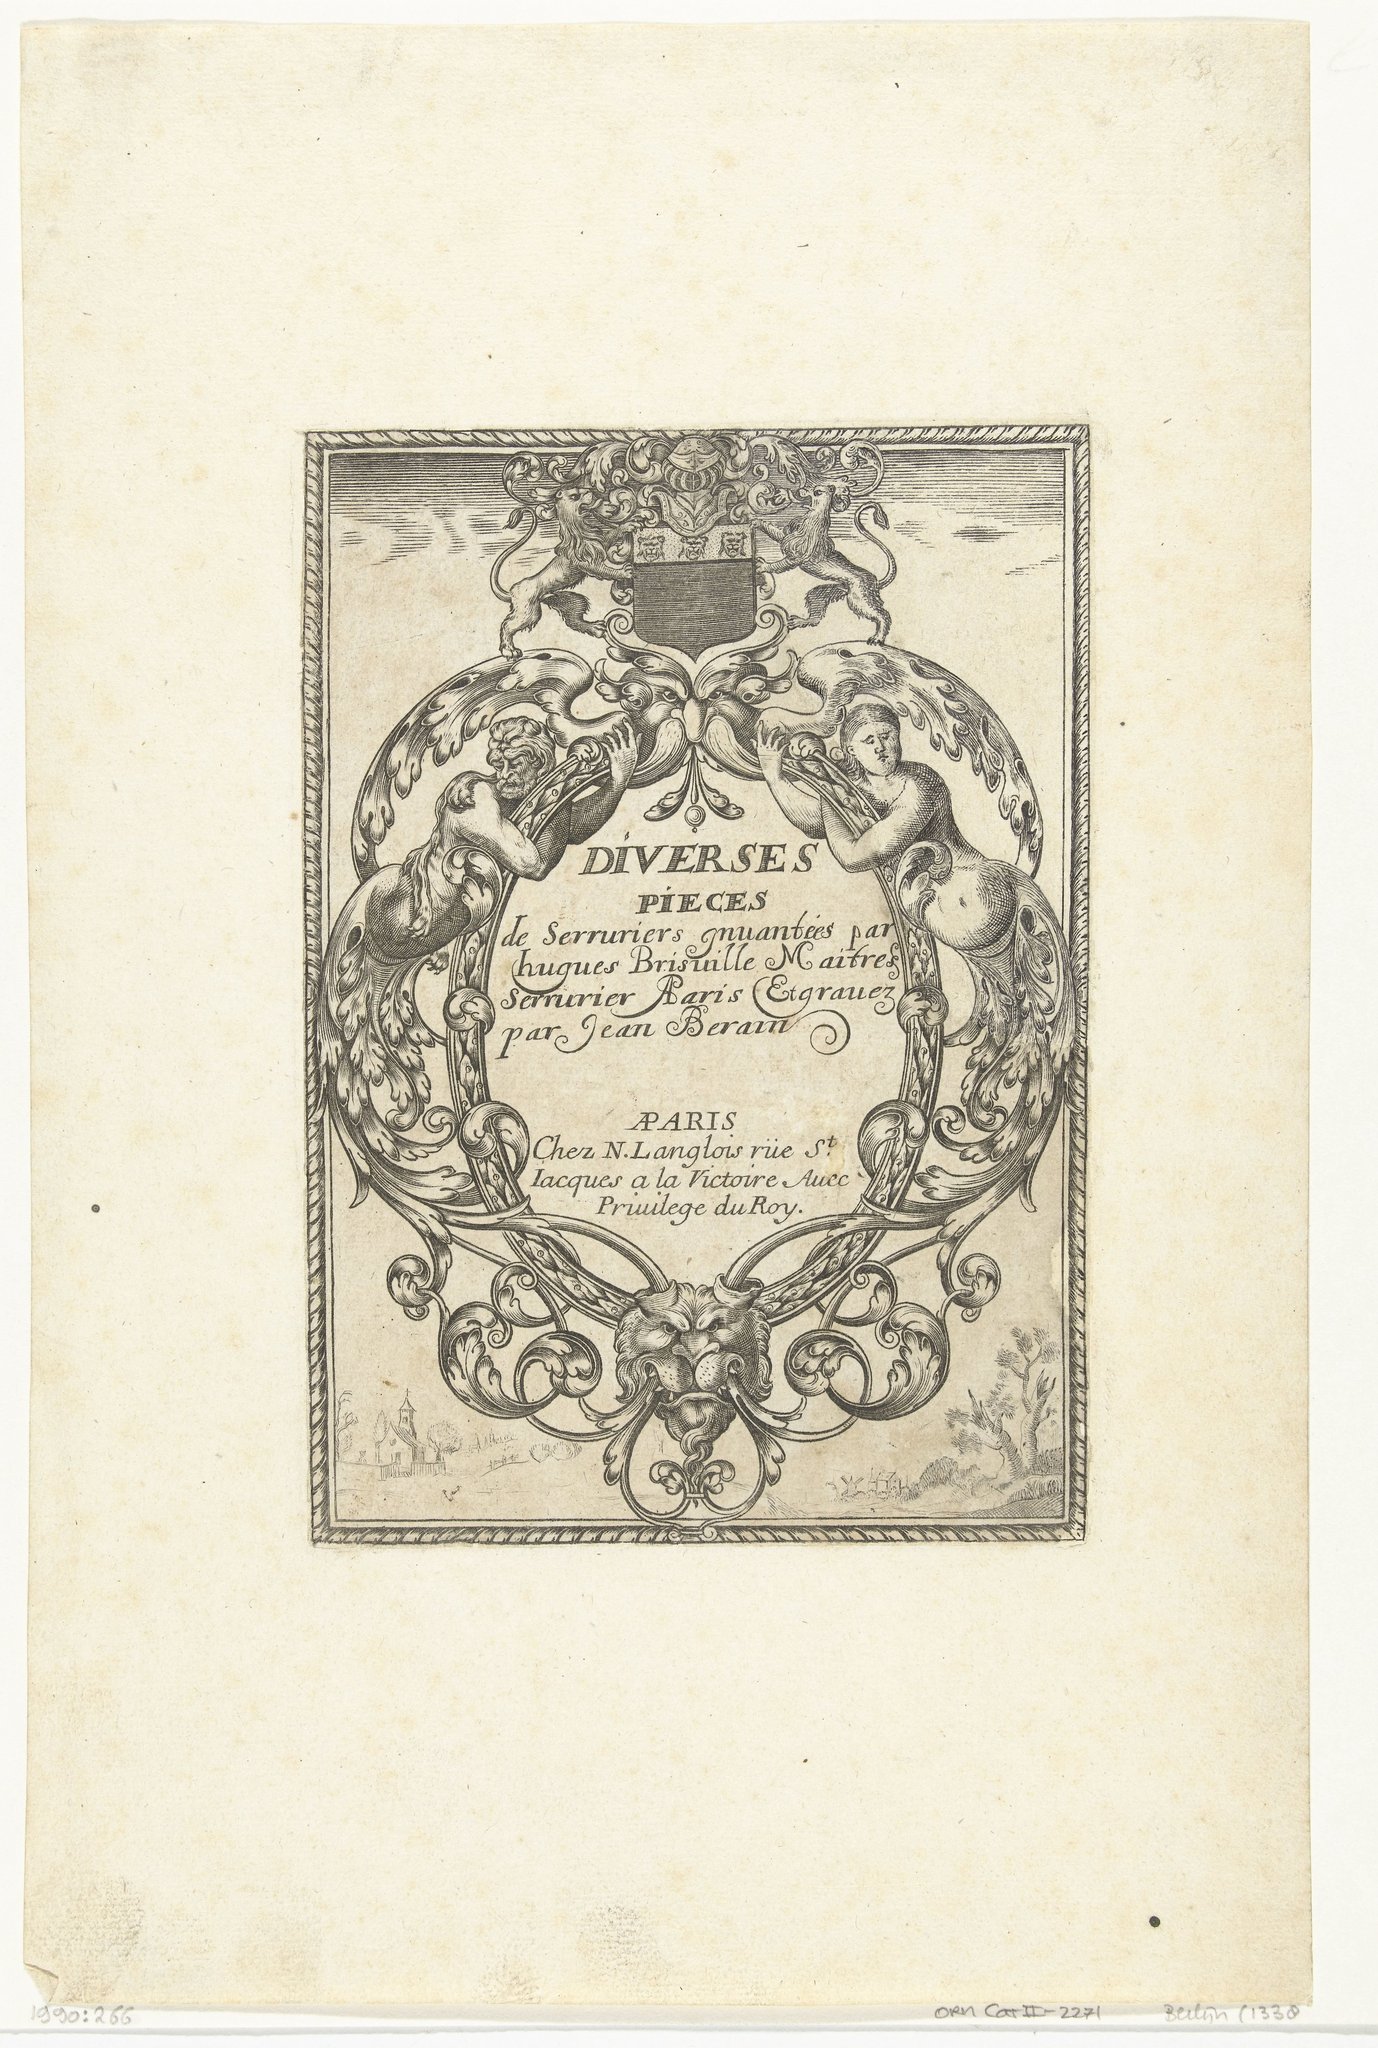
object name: print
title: Diverses Pièces de Serruriers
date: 1662-1711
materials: paper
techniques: engraving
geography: paris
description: De tekst staat in een cartouche met bovenaan een masker en onderaan een leeuwenkop. Blad 1 uit serie van titelblad, blad met opdracht en 14 bladen met beslag en smeedwerk, sleutelgatplaten, sleutels, deurkloppers en deurknoppen. Tweede editie.